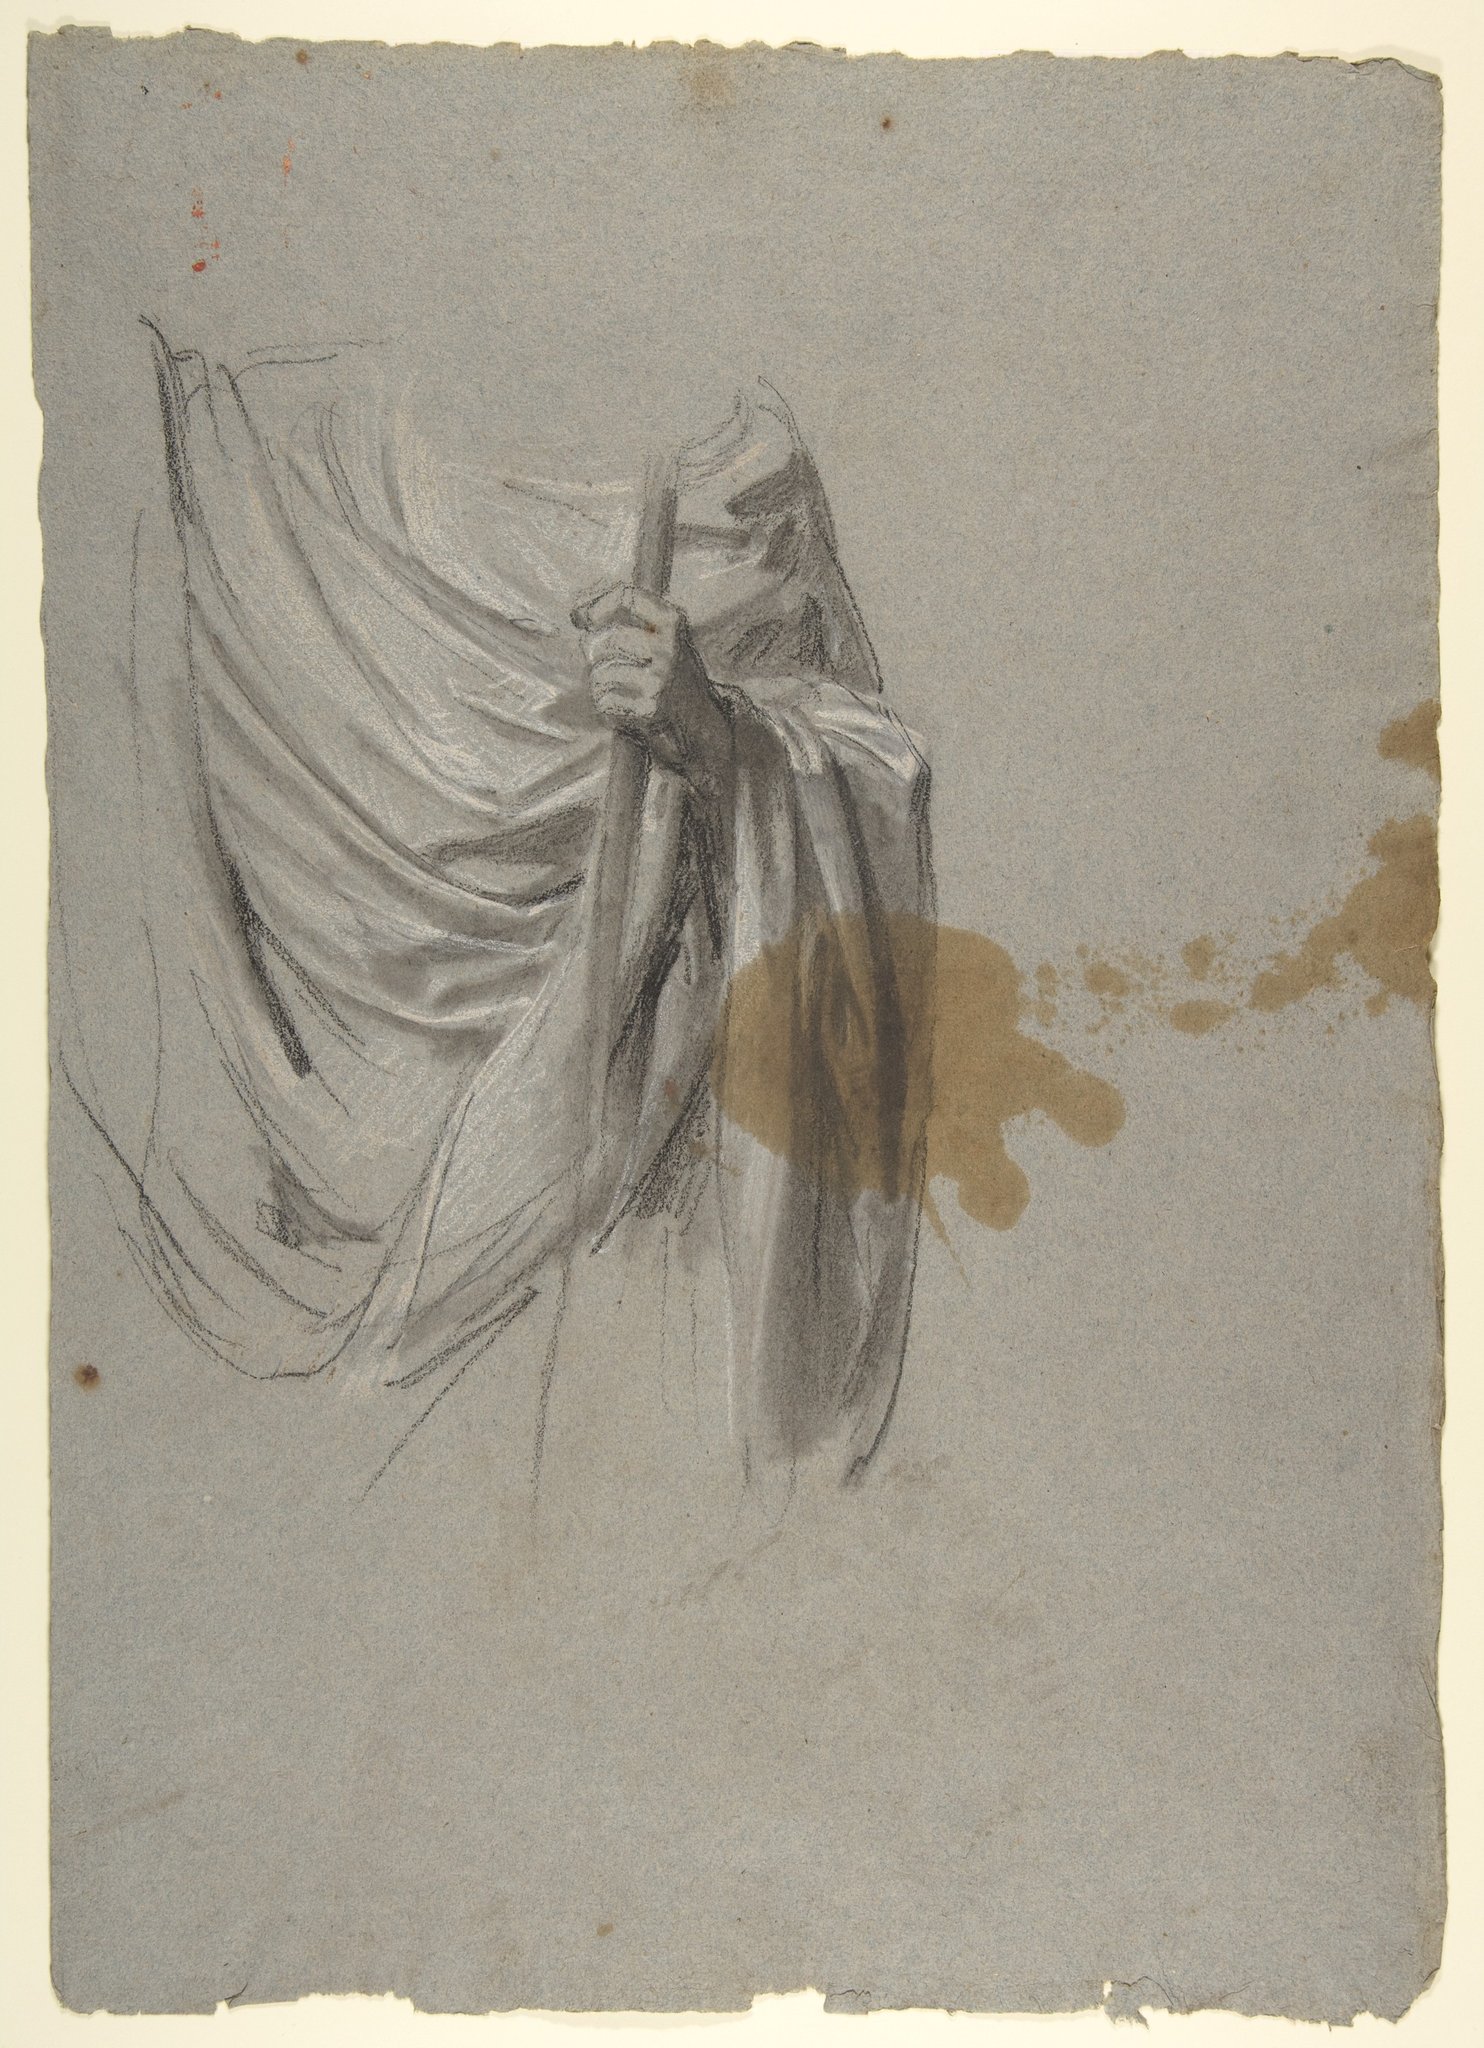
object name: drawing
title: Drapery Study for Saint Remi (middle register; study for wall paintings in the Chapel of Saint Remi, Sainte-Clotilde, Paris, 1858)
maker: isidore pils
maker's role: artist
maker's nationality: french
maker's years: 1813-1875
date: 1801-1900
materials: chalk, paper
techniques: heightening, stumping